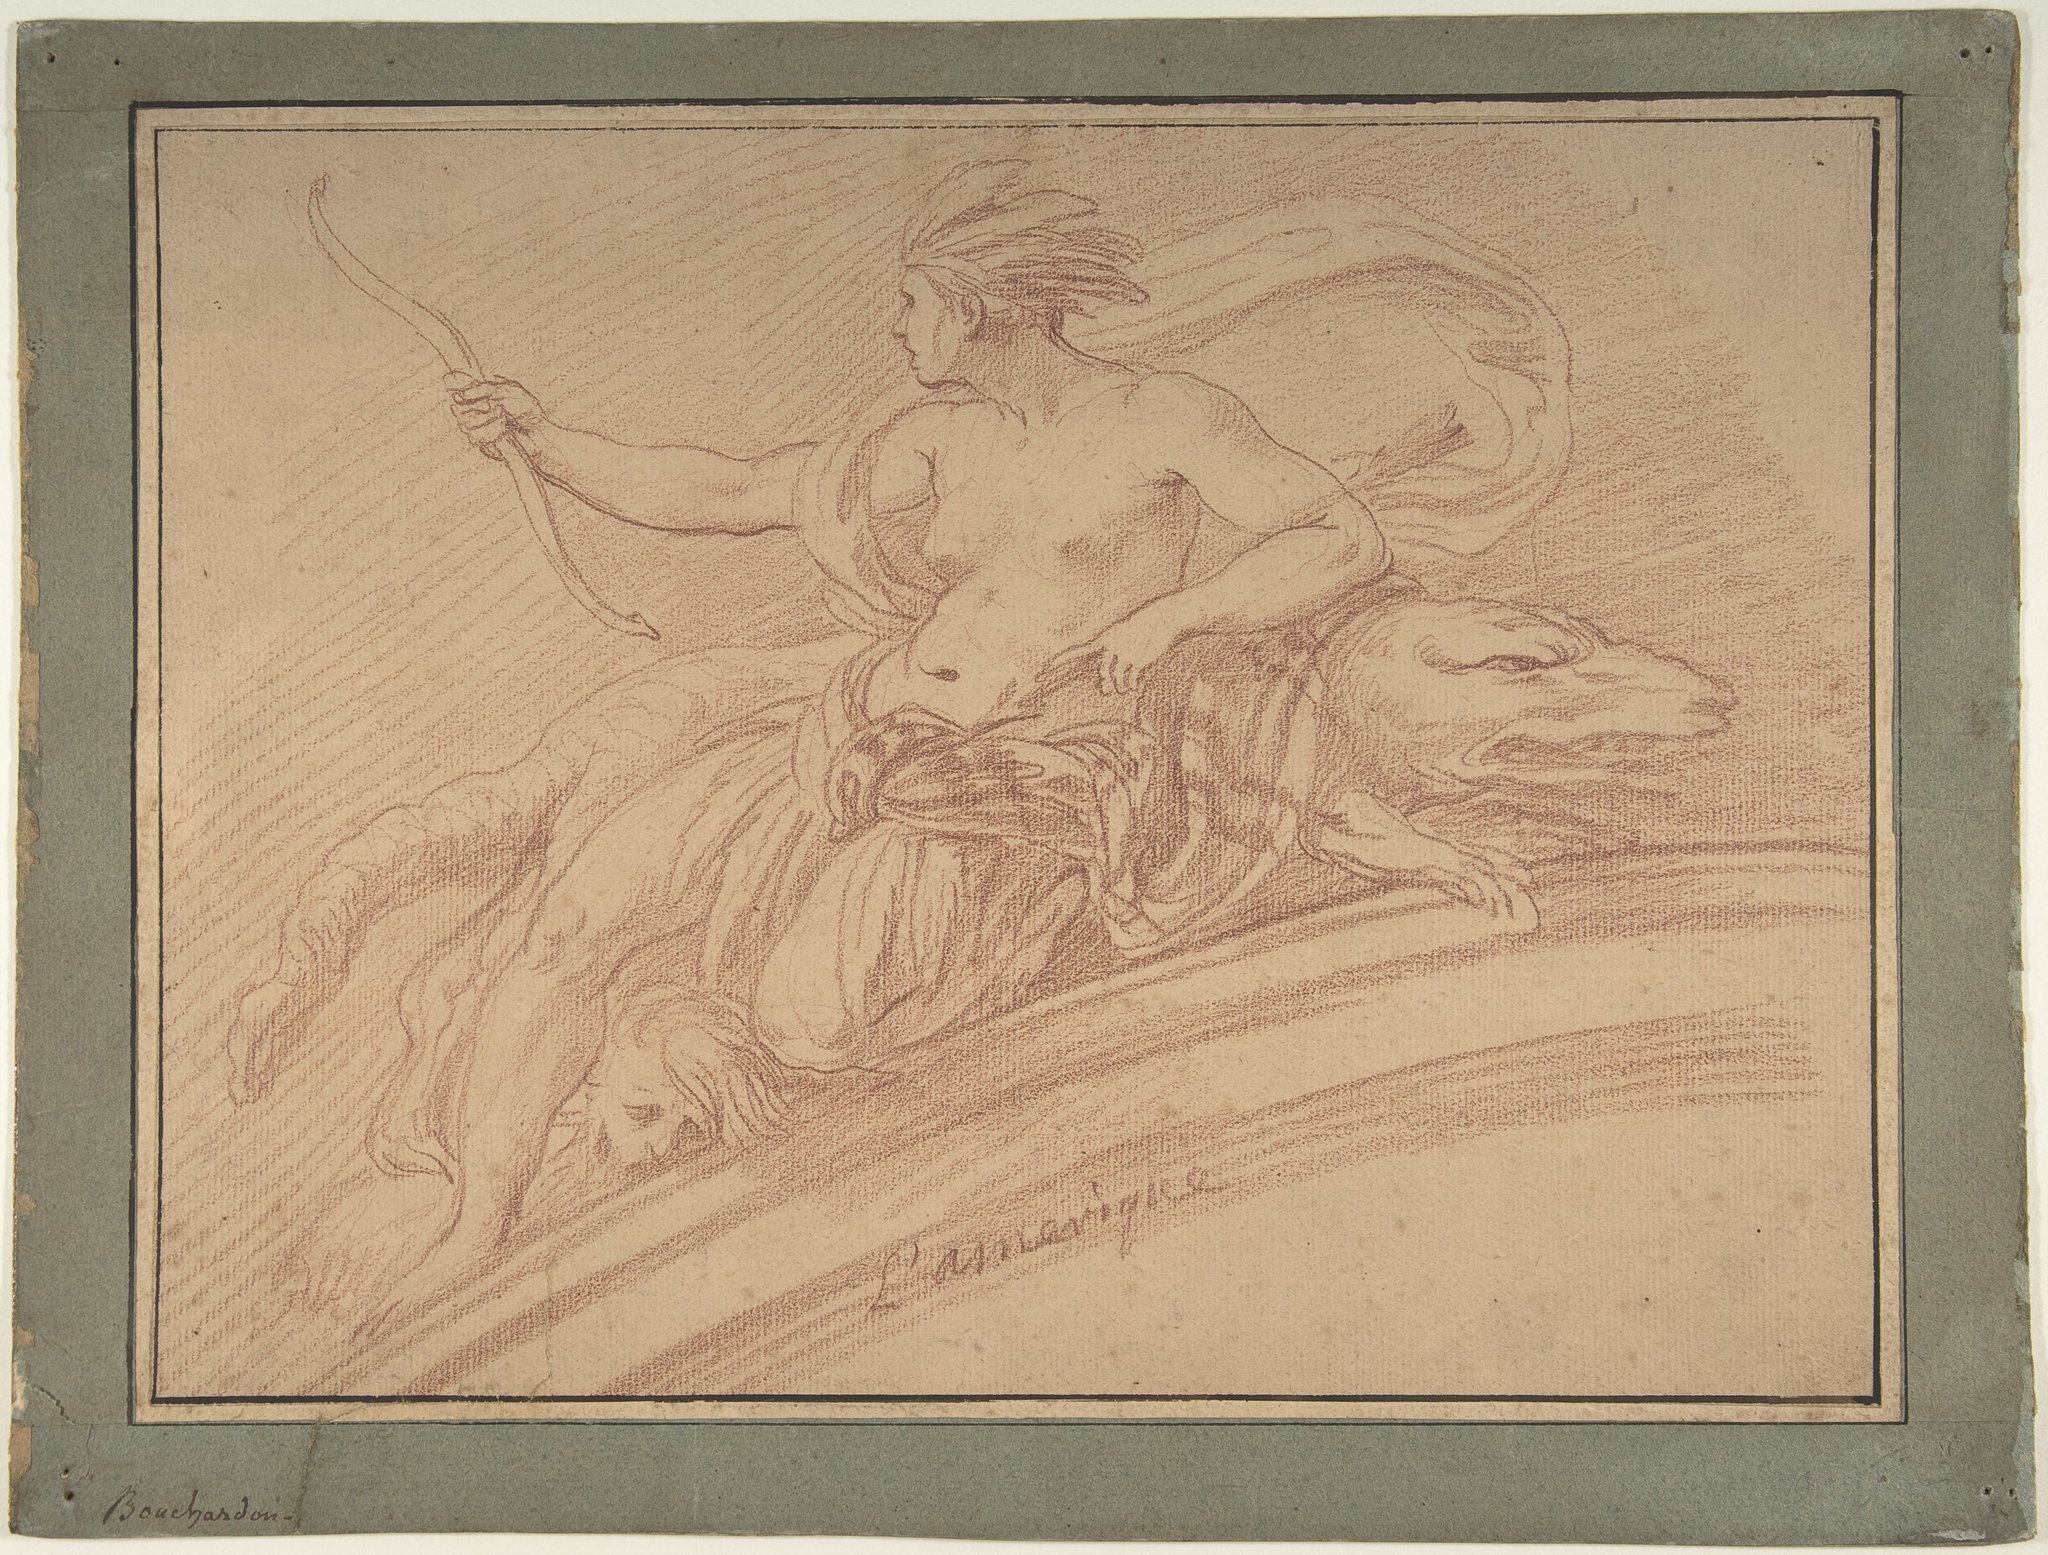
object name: drawing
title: Allegory of America, from the Four Continents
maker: edme bouchardon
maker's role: artist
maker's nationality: french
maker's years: 1698-1762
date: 1701-1800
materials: chalk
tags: animals,bow and arrow,men